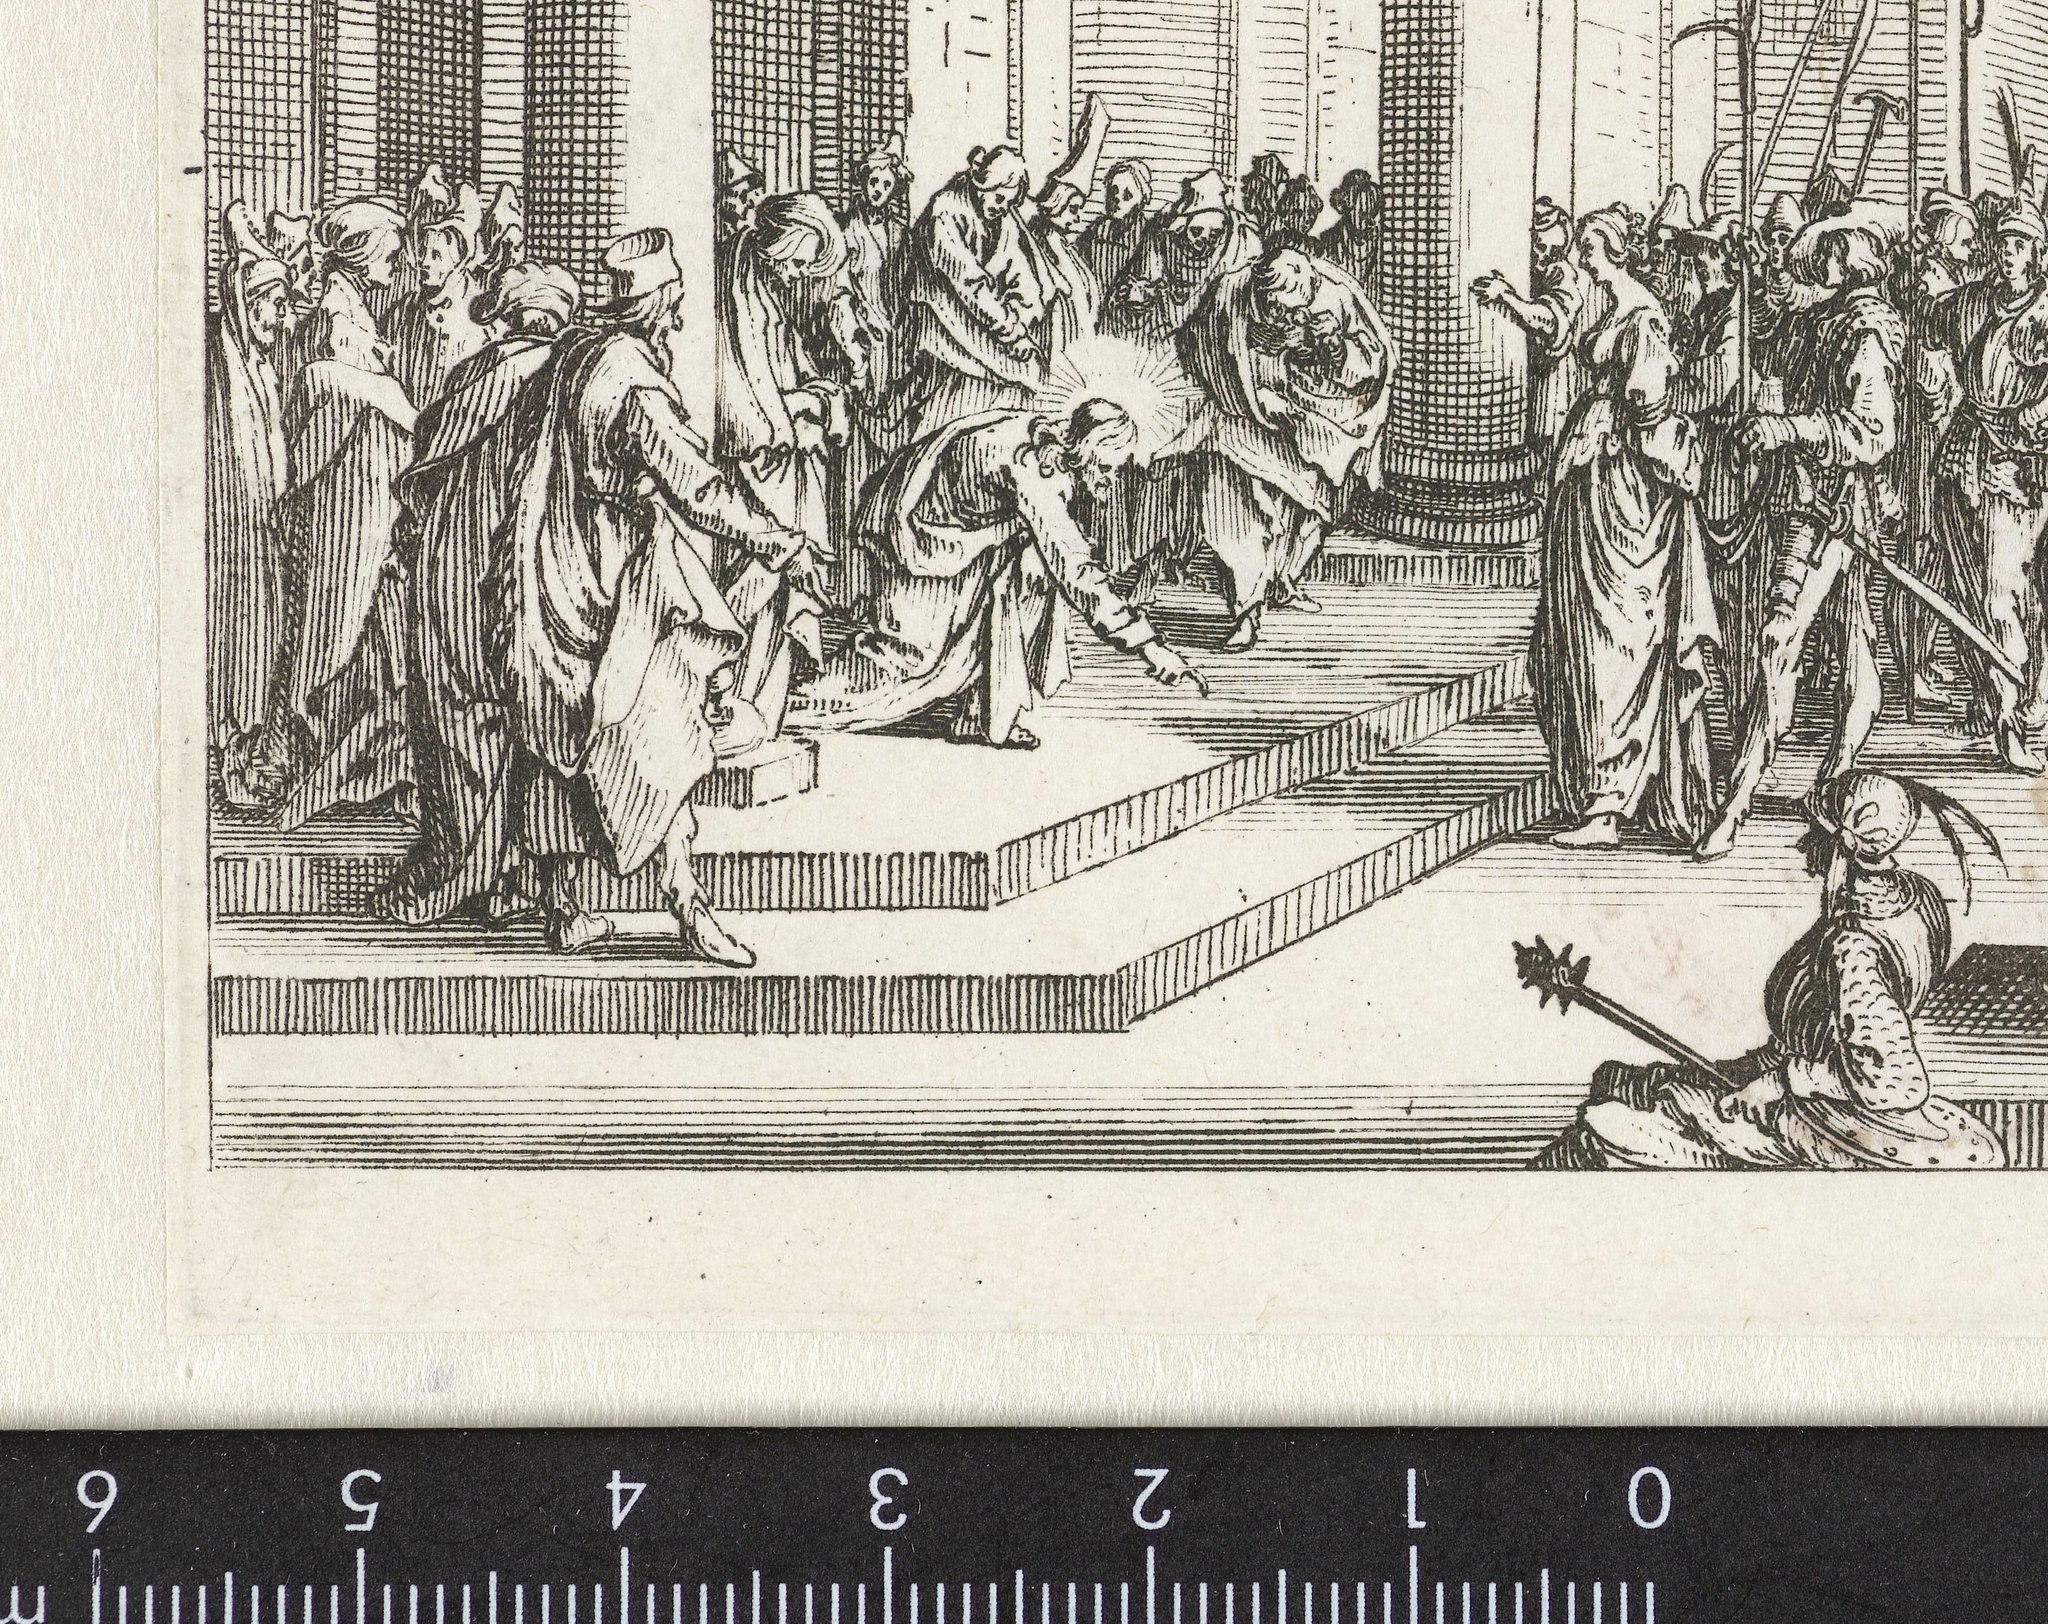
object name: print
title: Christus en de overspelige vrouw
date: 1635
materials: paper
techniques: etching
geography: paris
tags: christ points to or writes on the ground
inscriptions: collector's mark: Lugt 240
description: Christus buigt zich voorover en schrijft met zijn vinger iets op de grond, voor de voeten van een vrouw die door soldaten aan hem voorgeleid is. Deze prent is onderdeel van een reeks van tien prenten met voorstellingen uit het Nieuwe Testament, waaraan na Callots dood een titelprent is toegevoegd.